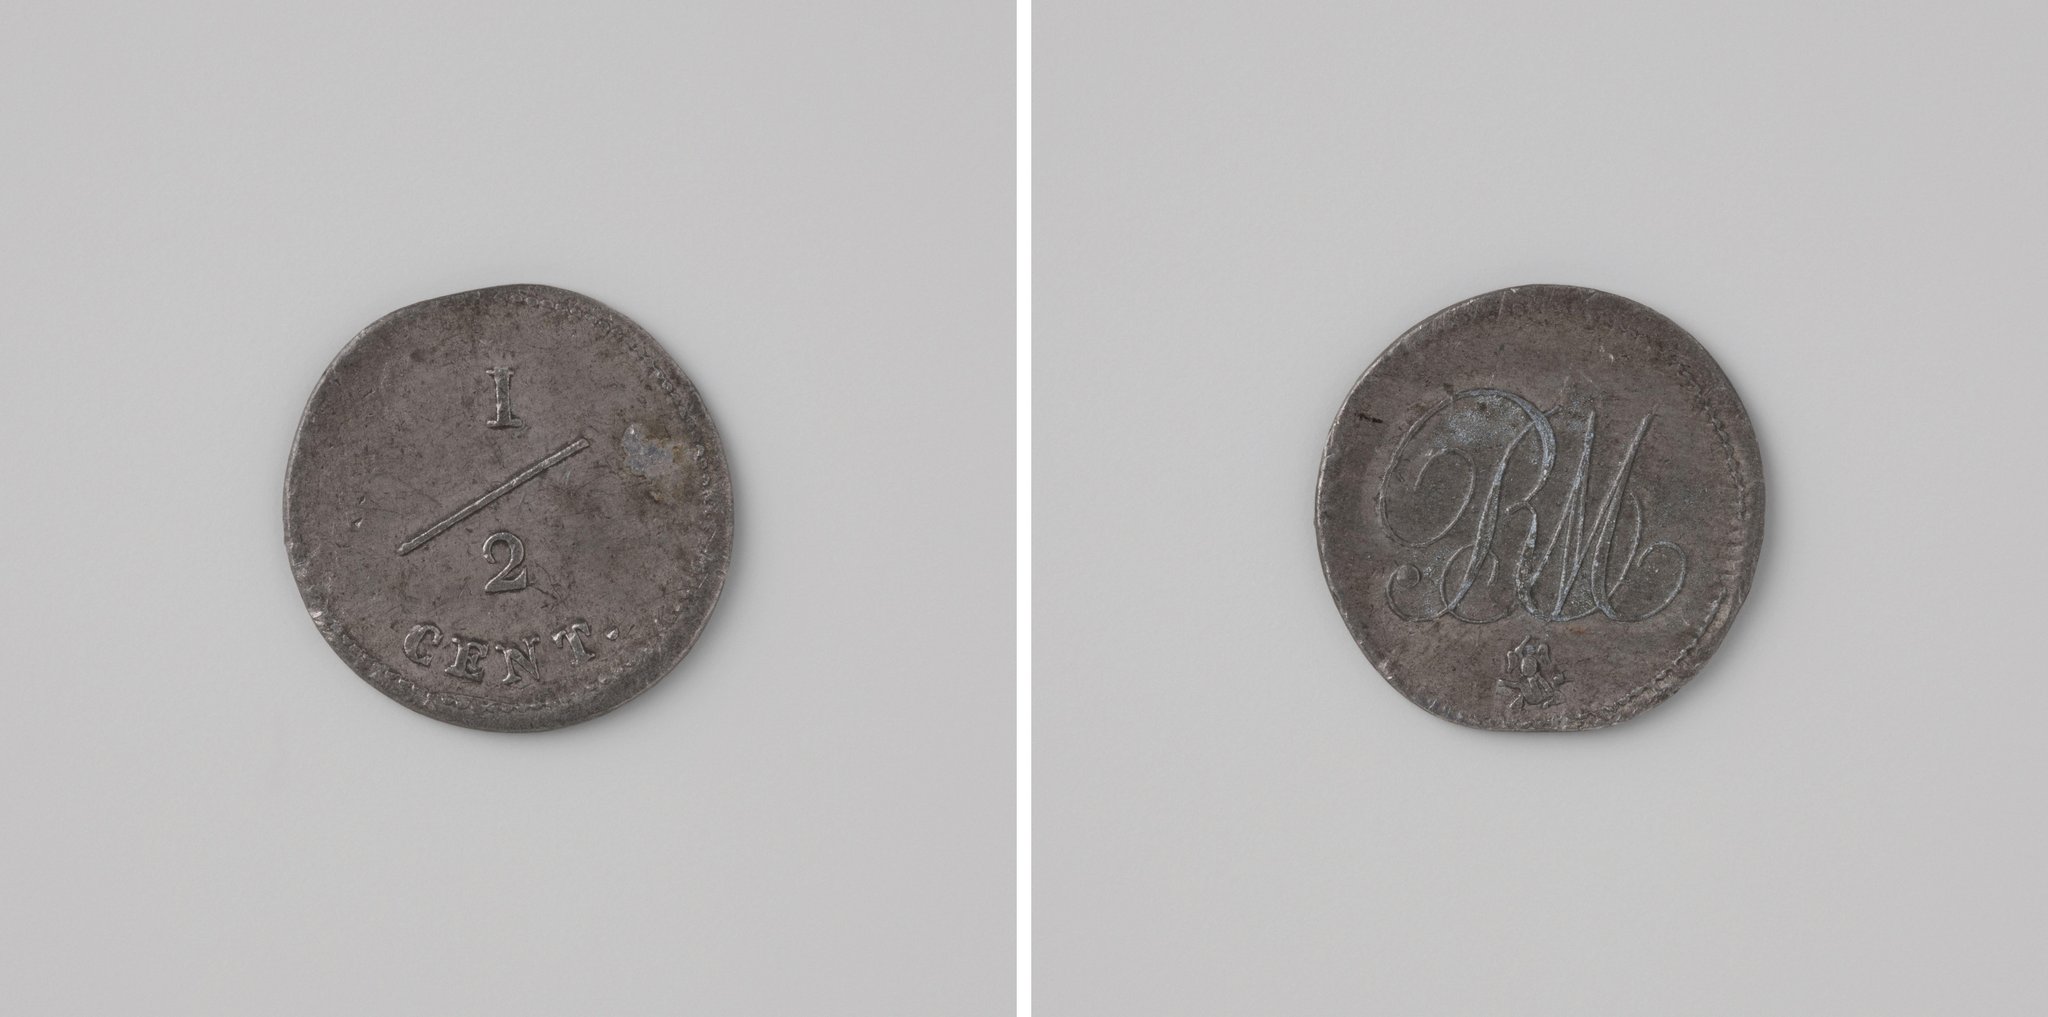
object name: medal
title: Huismunt van de kolonies Rijkevorsel en Merksplas ter waarde van ½ cent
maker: Anonymous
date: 1823-1839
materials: zinc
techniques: striking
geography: brussels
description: Zinken munt. Voorzijde: monogram van letters R en M boven merktekentje. Keerzijde: waardeaanduiding